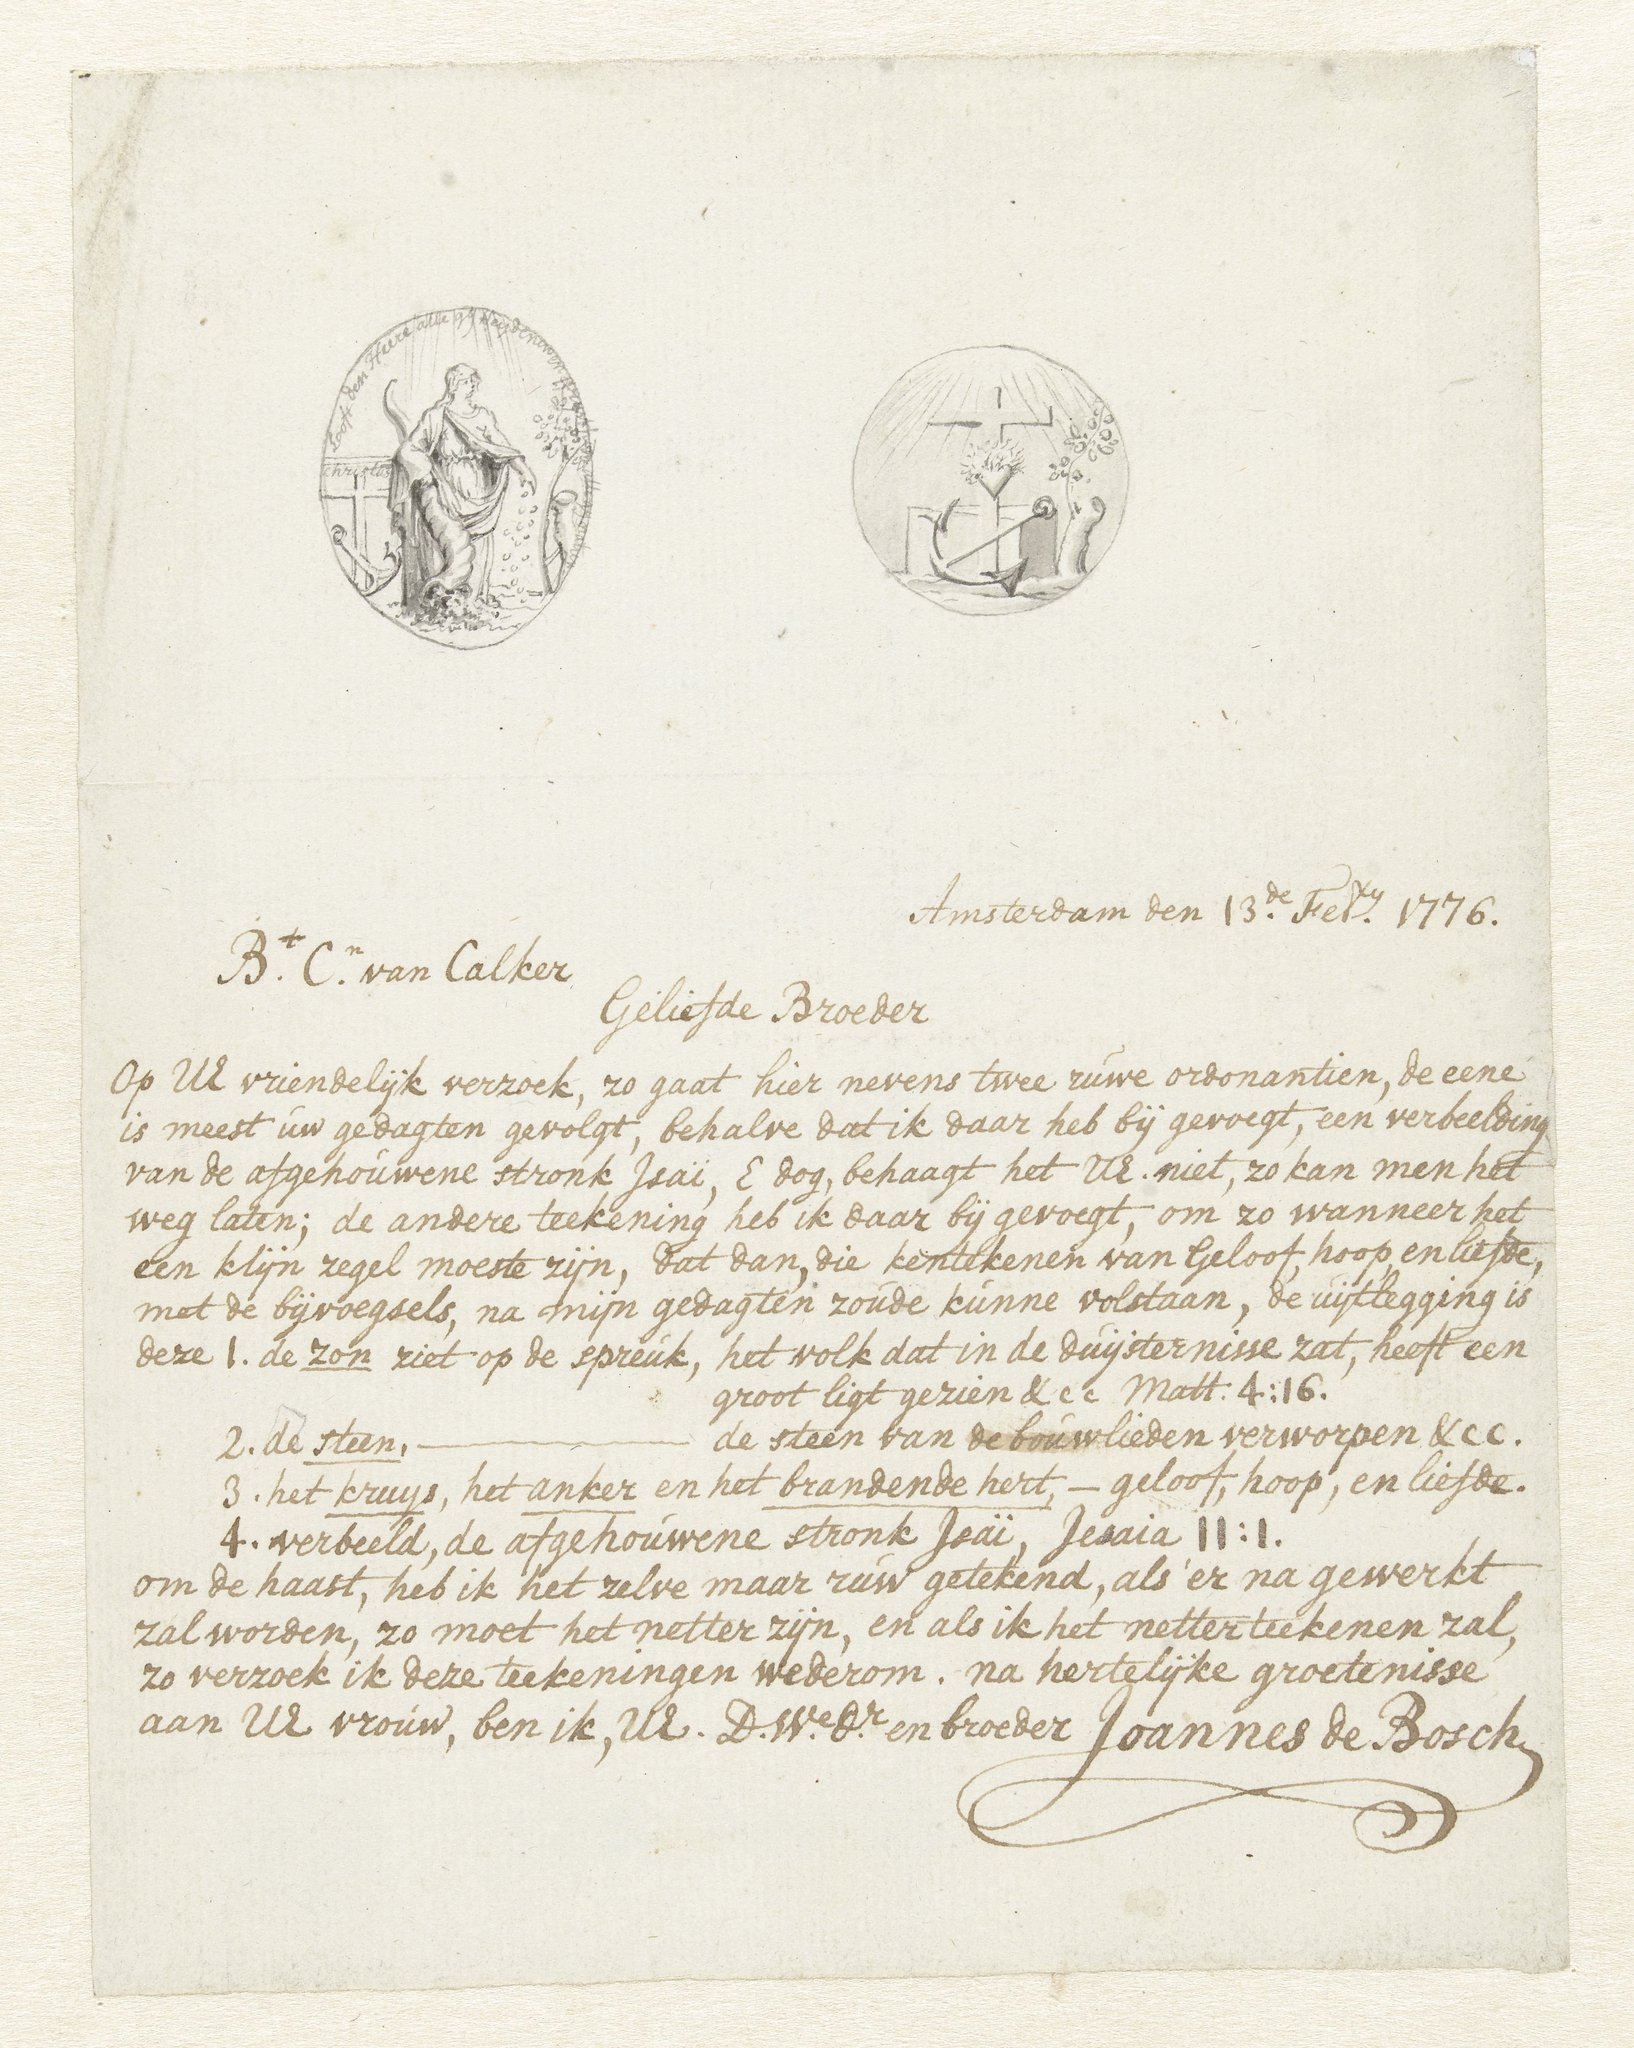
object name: letter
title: Brief met twee ontwerpen voor allegorische vignetten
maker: johannes de bosch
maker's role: draughtsman, print maker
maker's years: 1713-1785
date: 1776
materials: ink, paper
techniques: brush, pen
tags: the three theological virtues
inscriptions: date: ‘den 13de Feb. 1776’